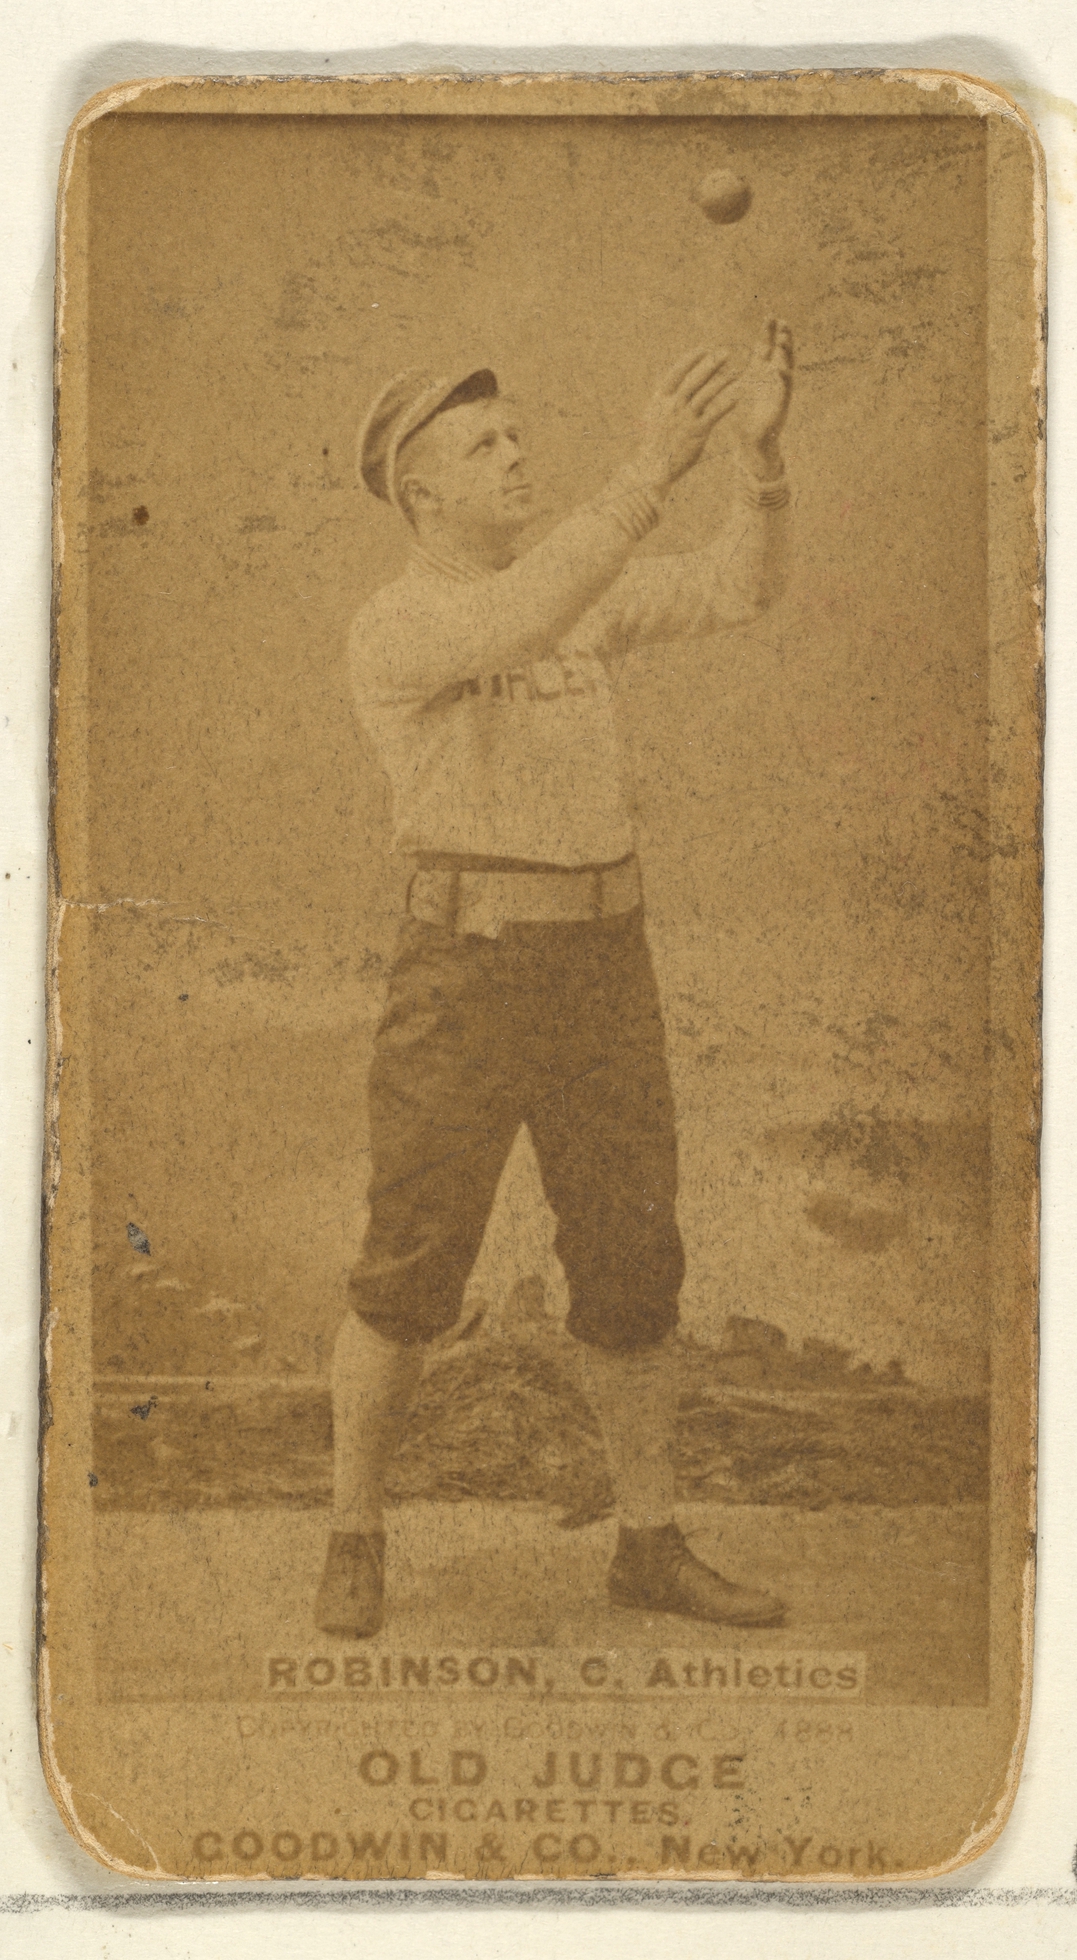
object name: baseball card, photograph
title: Robinson, Catcher, Philadelphia Athletics, from the Old Judge series (N172) for Old Judge Cigarettes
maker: goodwin & company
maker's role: publisher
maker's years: 1850-1950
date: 1888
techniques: albumen silver print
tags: men,portraits,baseball,athletes